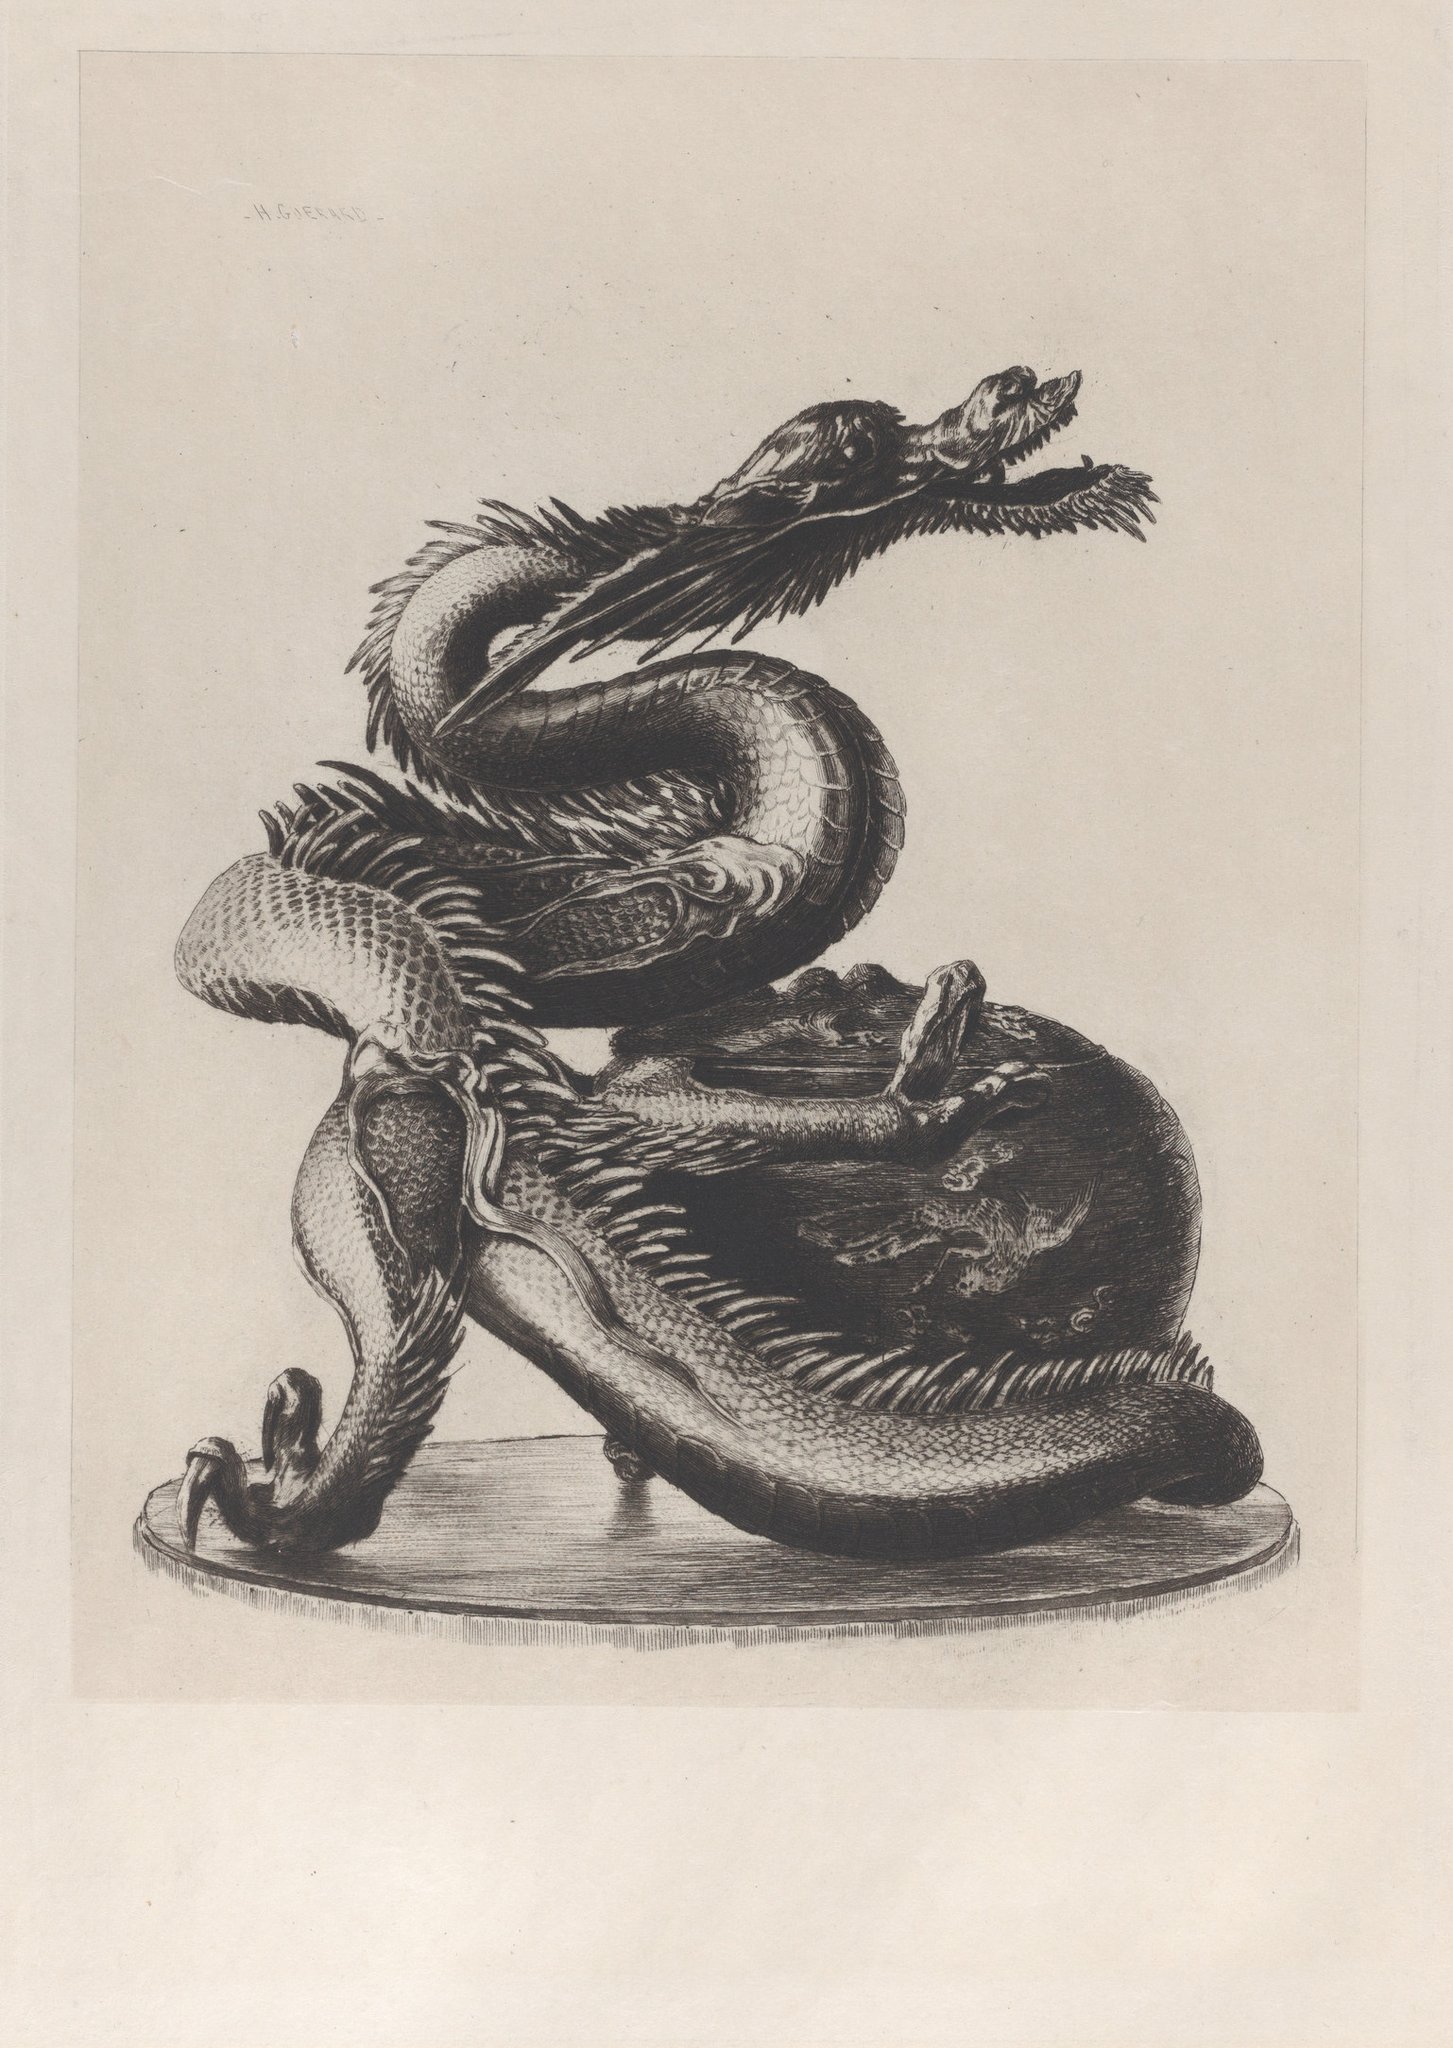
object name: print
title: Large Bronze Dragon Incense Burner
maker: henri charles guérard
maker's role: artist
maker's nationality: french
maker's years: 1846-1897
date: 1882-1883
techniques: drypoint, etching, roulette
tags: dragons